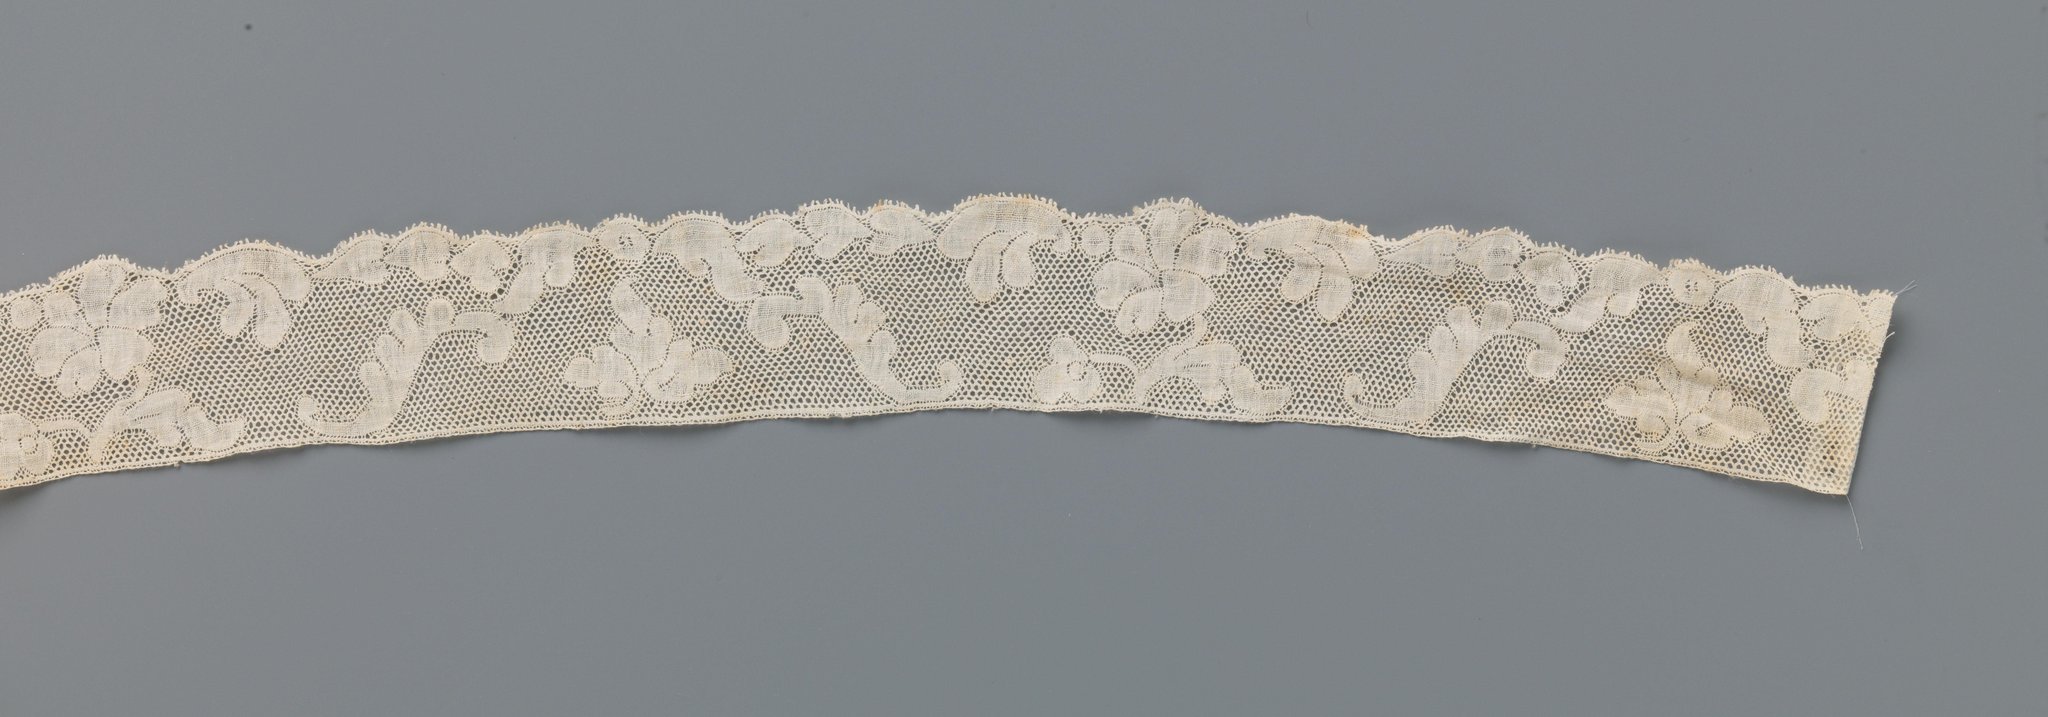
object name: strip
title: Strook kloskant met hangende tak en driehoekig blad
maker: Anonymous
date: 1740-1760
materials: linen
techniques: lace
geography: valenciennes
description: Strook naturelkleurige kloskant, Valenciennes-kant. Het zich herhalende patroon bestaat uit een hangende tak met één grote bloem die tot de onderrand hangt en één kleine drielobbig bloempje die zijwaarts langs de bovenrand buigt in tegenovergestelde richting van het blad. De tak hangt in een veld dat wordt begrensd door twee schuingestelde gerekte s-voluten en wordt in het volgende veld afgewisseld door een hangend driehoekig blad. De motieven zijn met elkaar verbonden door een maasgrond, de ronde Valenciennes-grond. De motieven zijn gemaakt in linnenslag met opengewerkte randjes. De schulpjes langs de onderzijde worden gevormd door de afhangende grote bloem en een aaneenschakeling van hartvormige motiefjes en enkele bladeren, ze zijn afgewerkt met picots. De bovenzijde van de strook is recht afgewerkt.